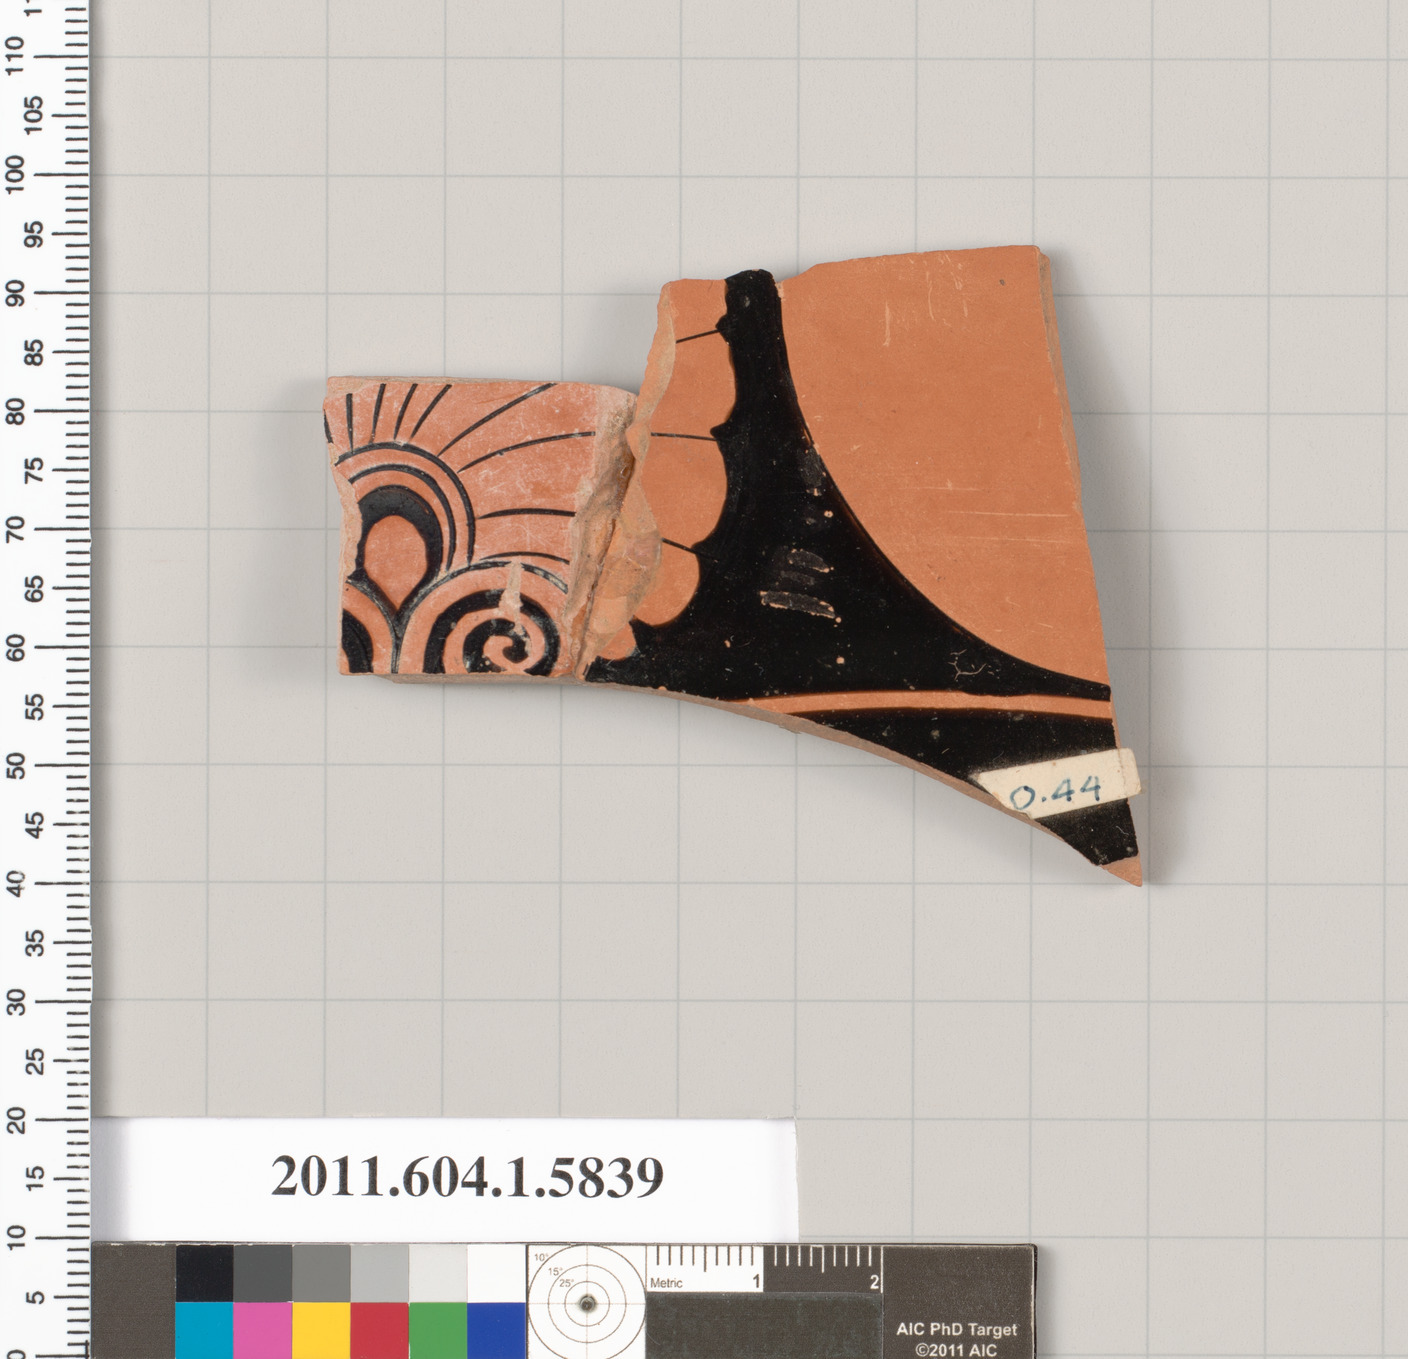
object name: kylix fragment, eye cup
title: Terracotta fragment of a kylix: eye-cup (drinking cup)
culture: greek, attic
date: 520-510 BCE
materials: terracotta